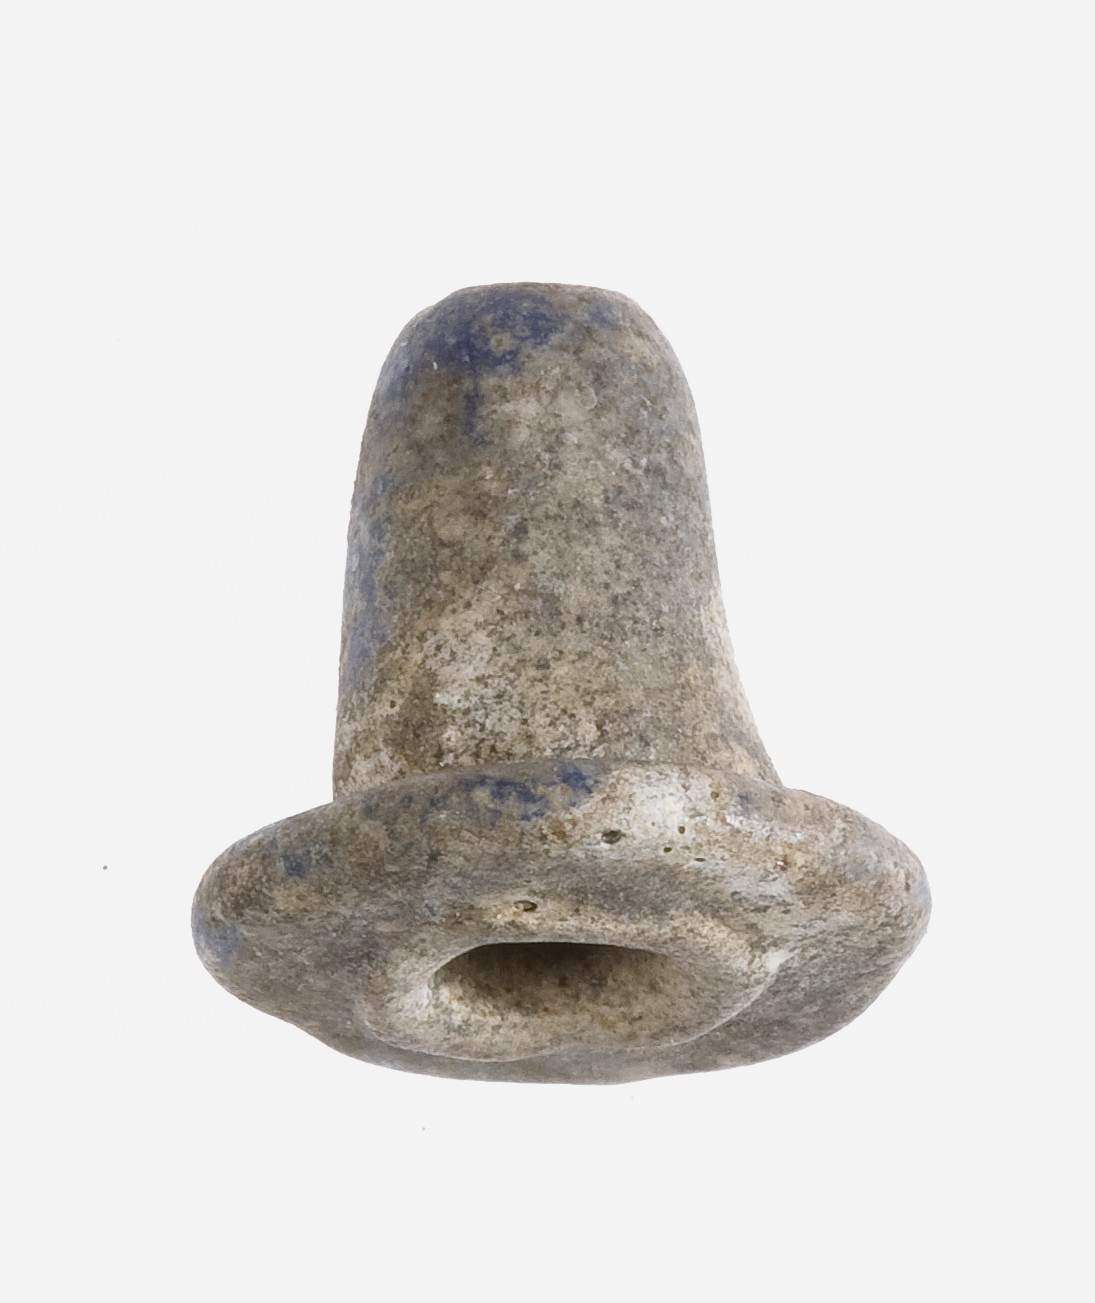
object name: pendant, umbel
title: Umbel Pendant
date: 1390-1352 BCE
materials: faience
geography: egypt